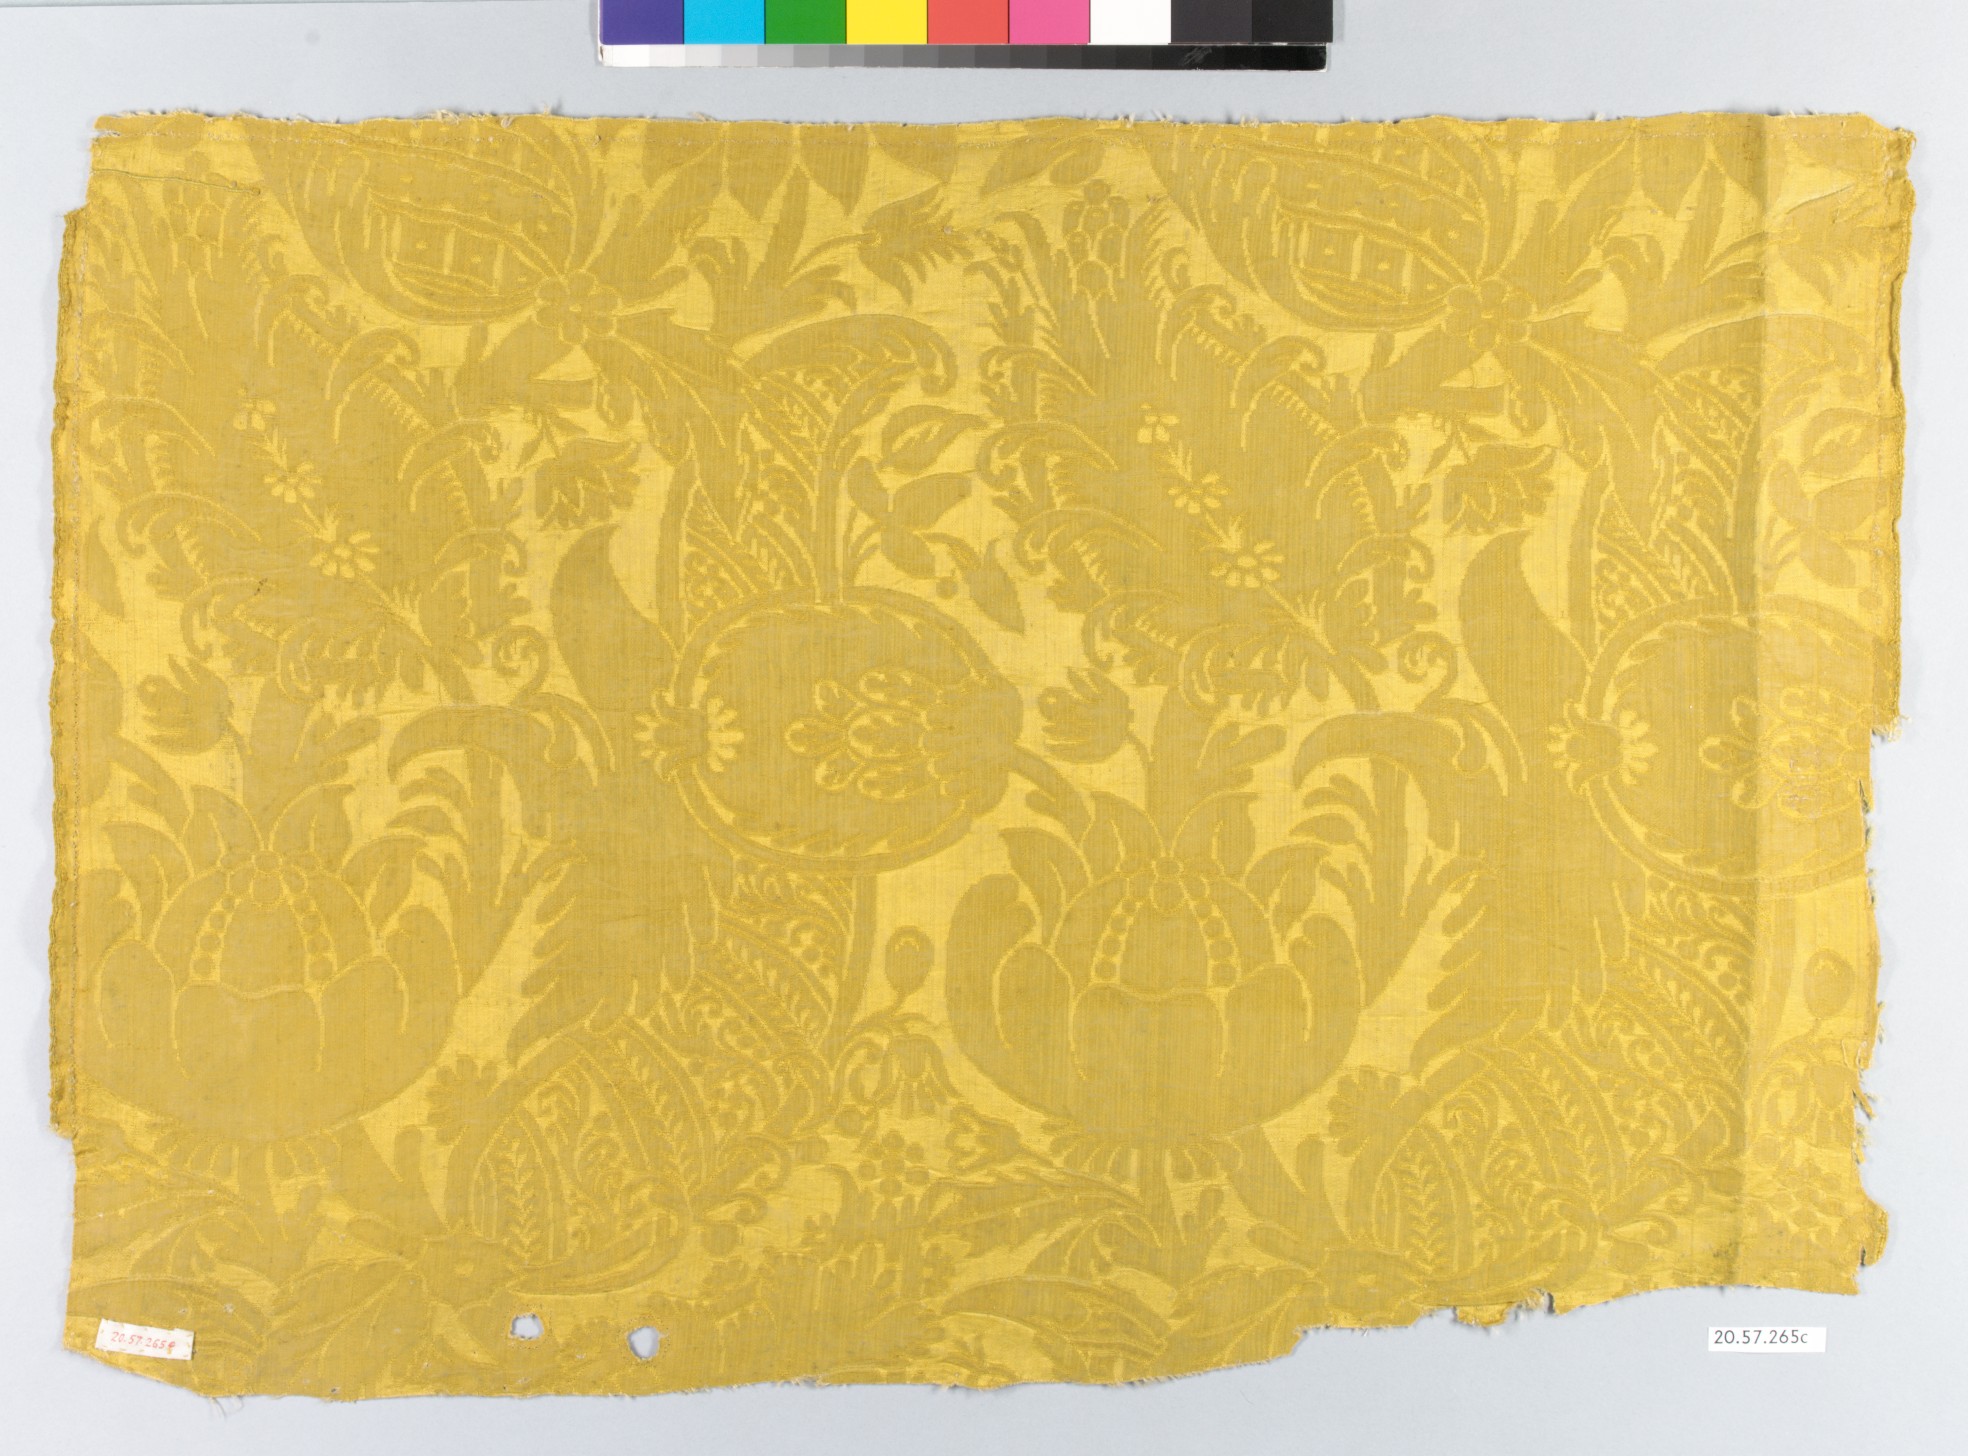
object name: piece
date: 1710-1720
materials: silk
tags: flowers,leaves